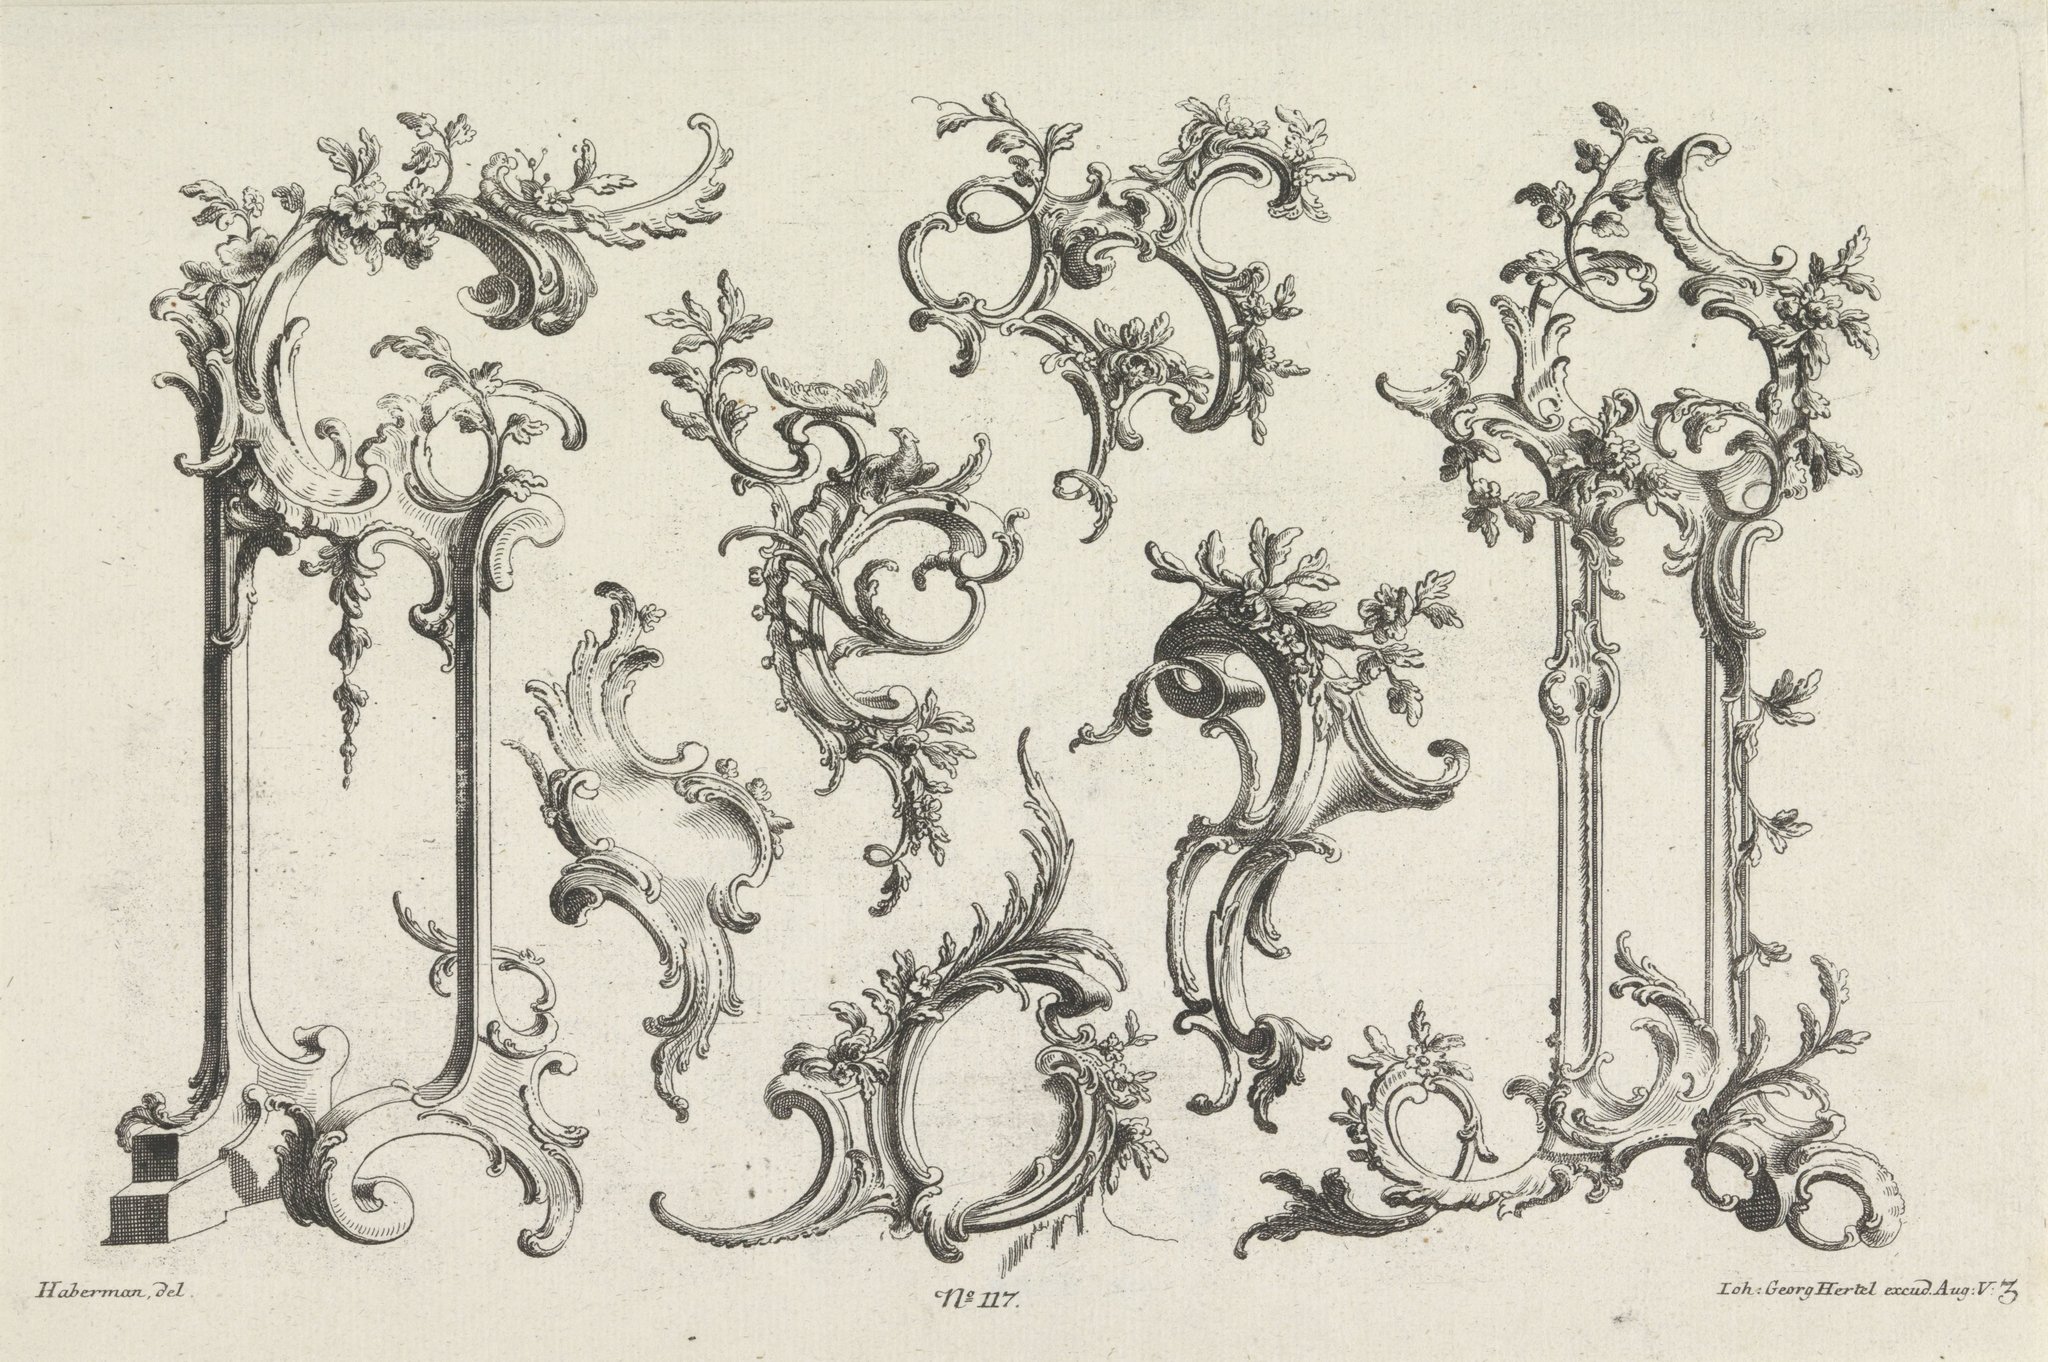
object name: print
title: Ontwerpen van rocaille-ornamenten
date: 1731-1775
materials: paper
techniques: etching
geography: augsburg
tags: rocaille ornament, birds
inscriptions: collector's mark: Lugt 2760, collector's mark: Lugt 2228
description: Rocaille ornamenten met bladmotieven en twee vogels. Uitgeversnummer 117.